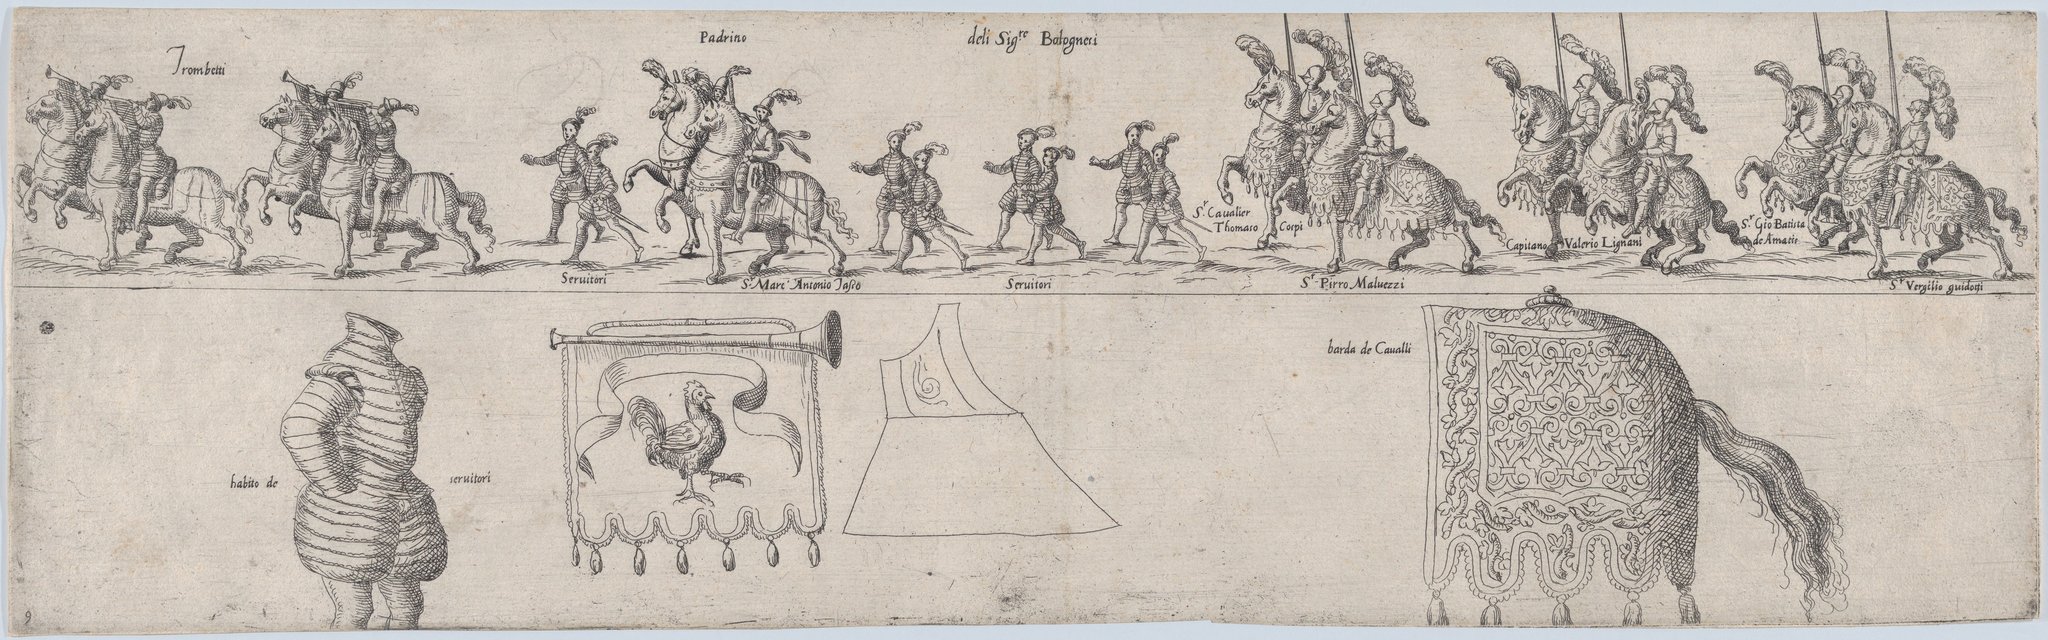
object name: print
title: Plate depicting Signore Bolognesi, from a series of twelve showing knights and their attendants dressed for a tournament (plate 9)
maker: Anonymous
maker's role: artist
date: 1565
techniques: etching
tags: men,horses,knights